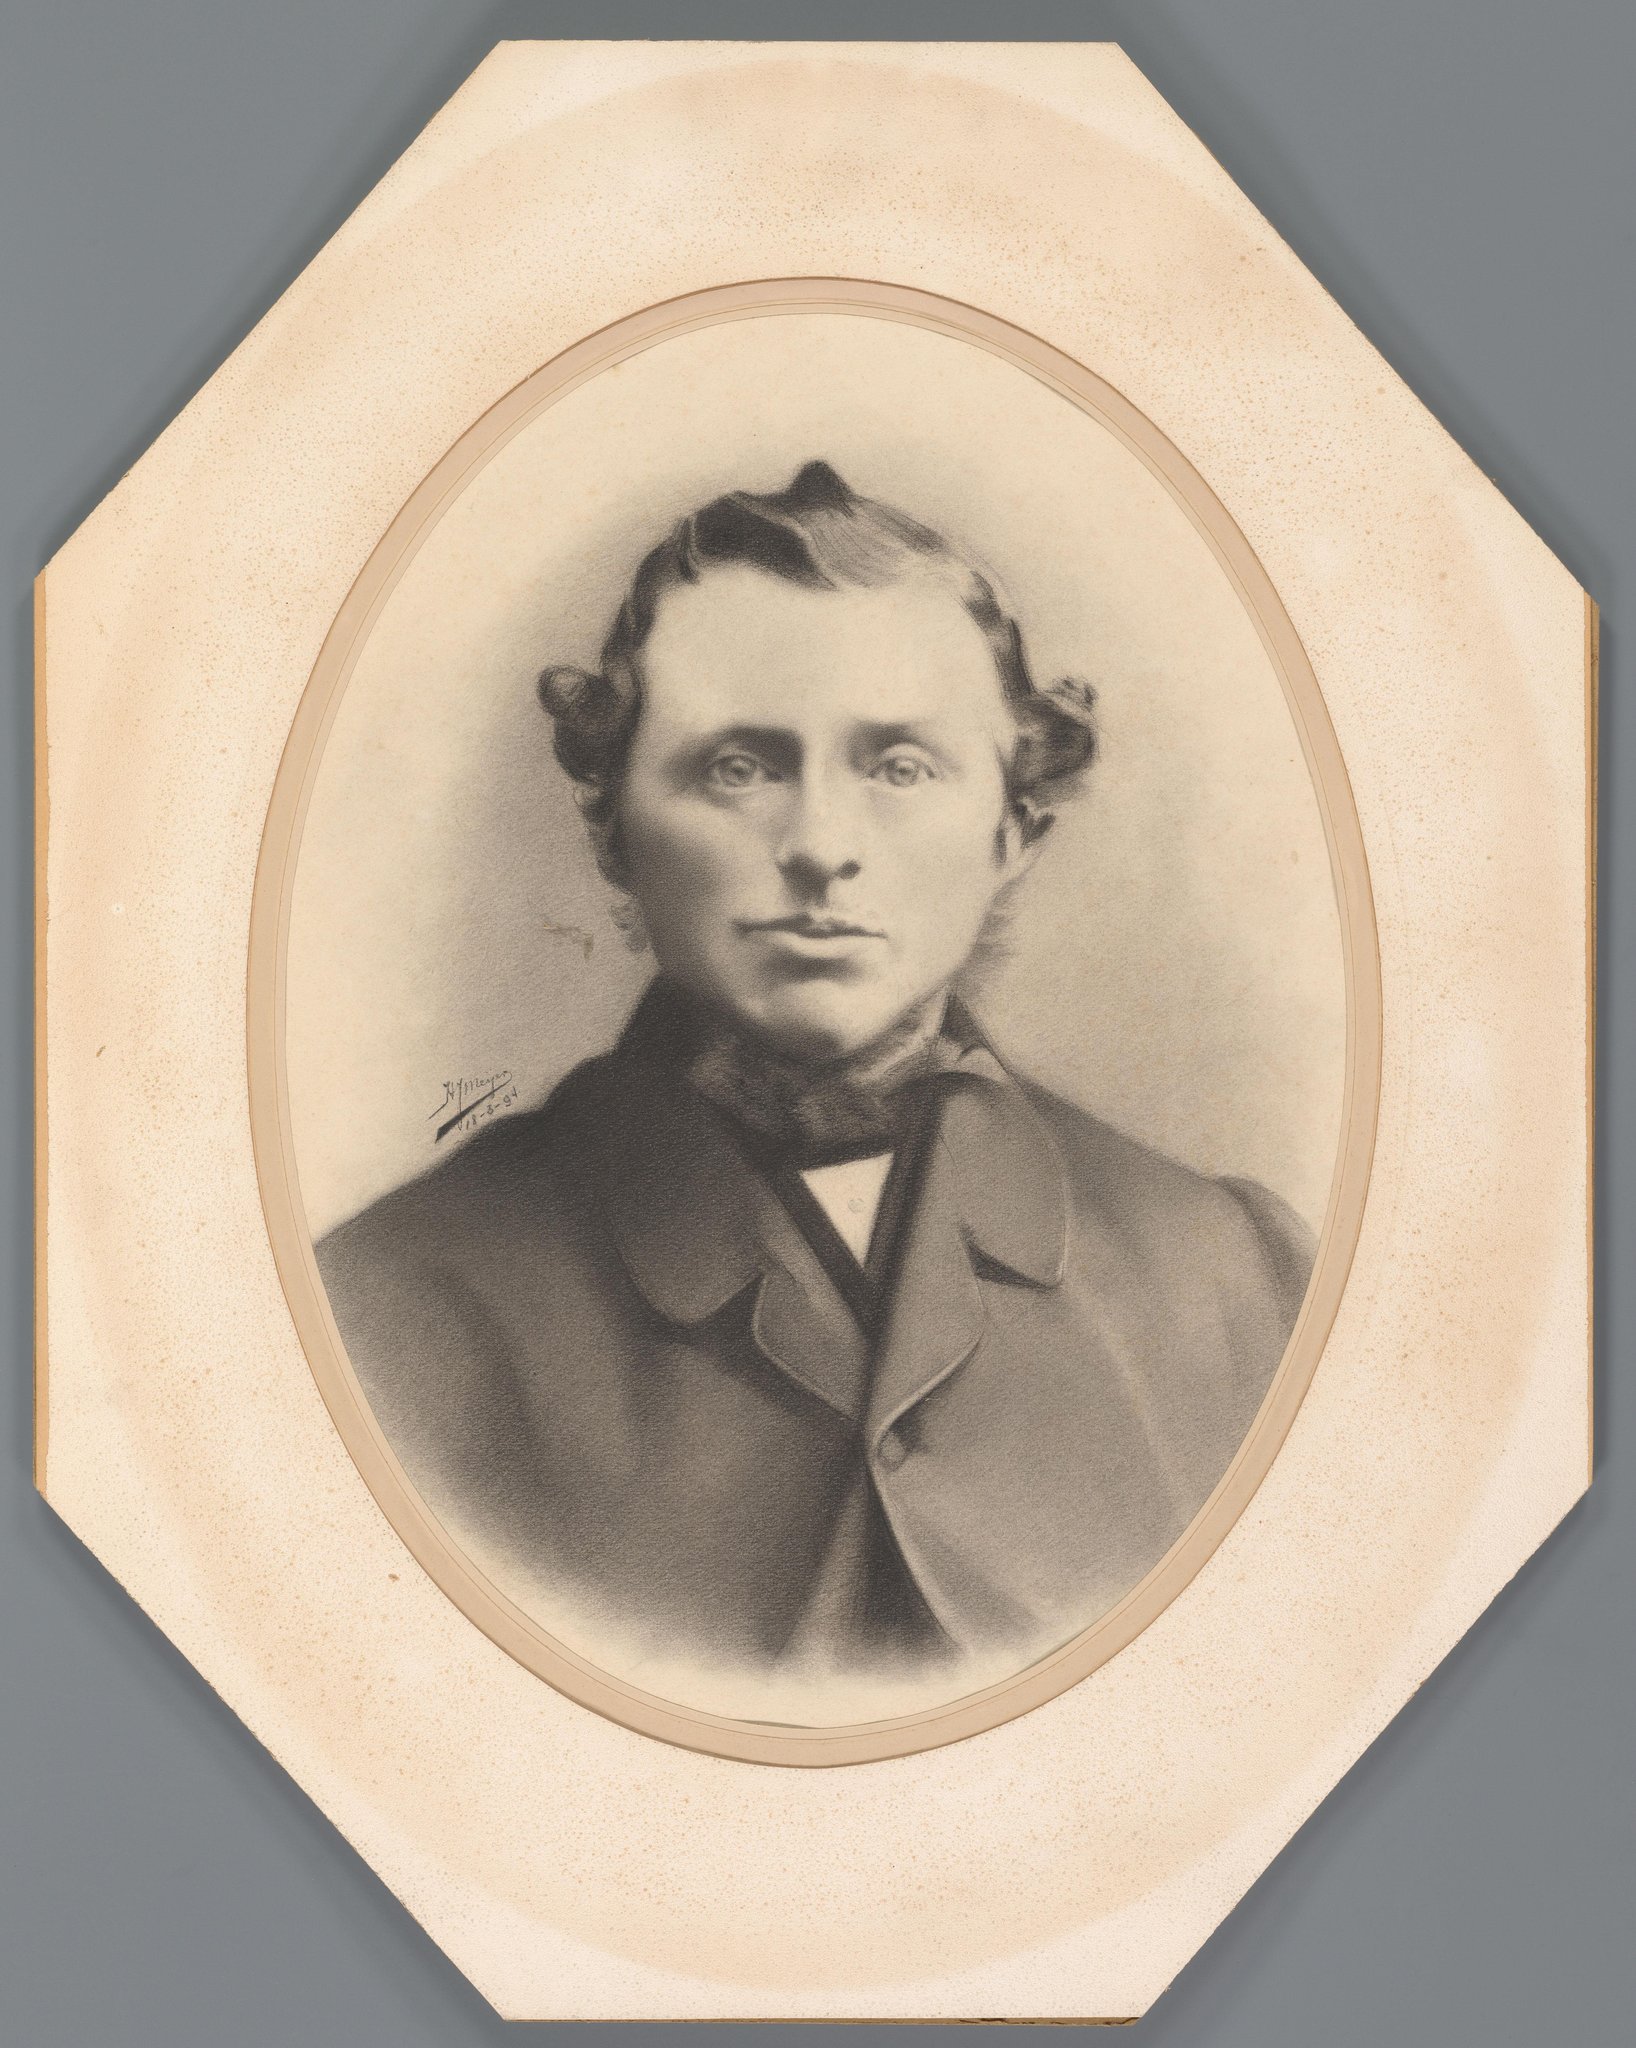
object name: crayon enlargement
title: Portret van een onbekende man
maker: a.j. meijer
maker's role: fotograaf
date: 1894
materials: paper, chalk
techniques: gelatin silver print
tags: anonymous historical person portrayed